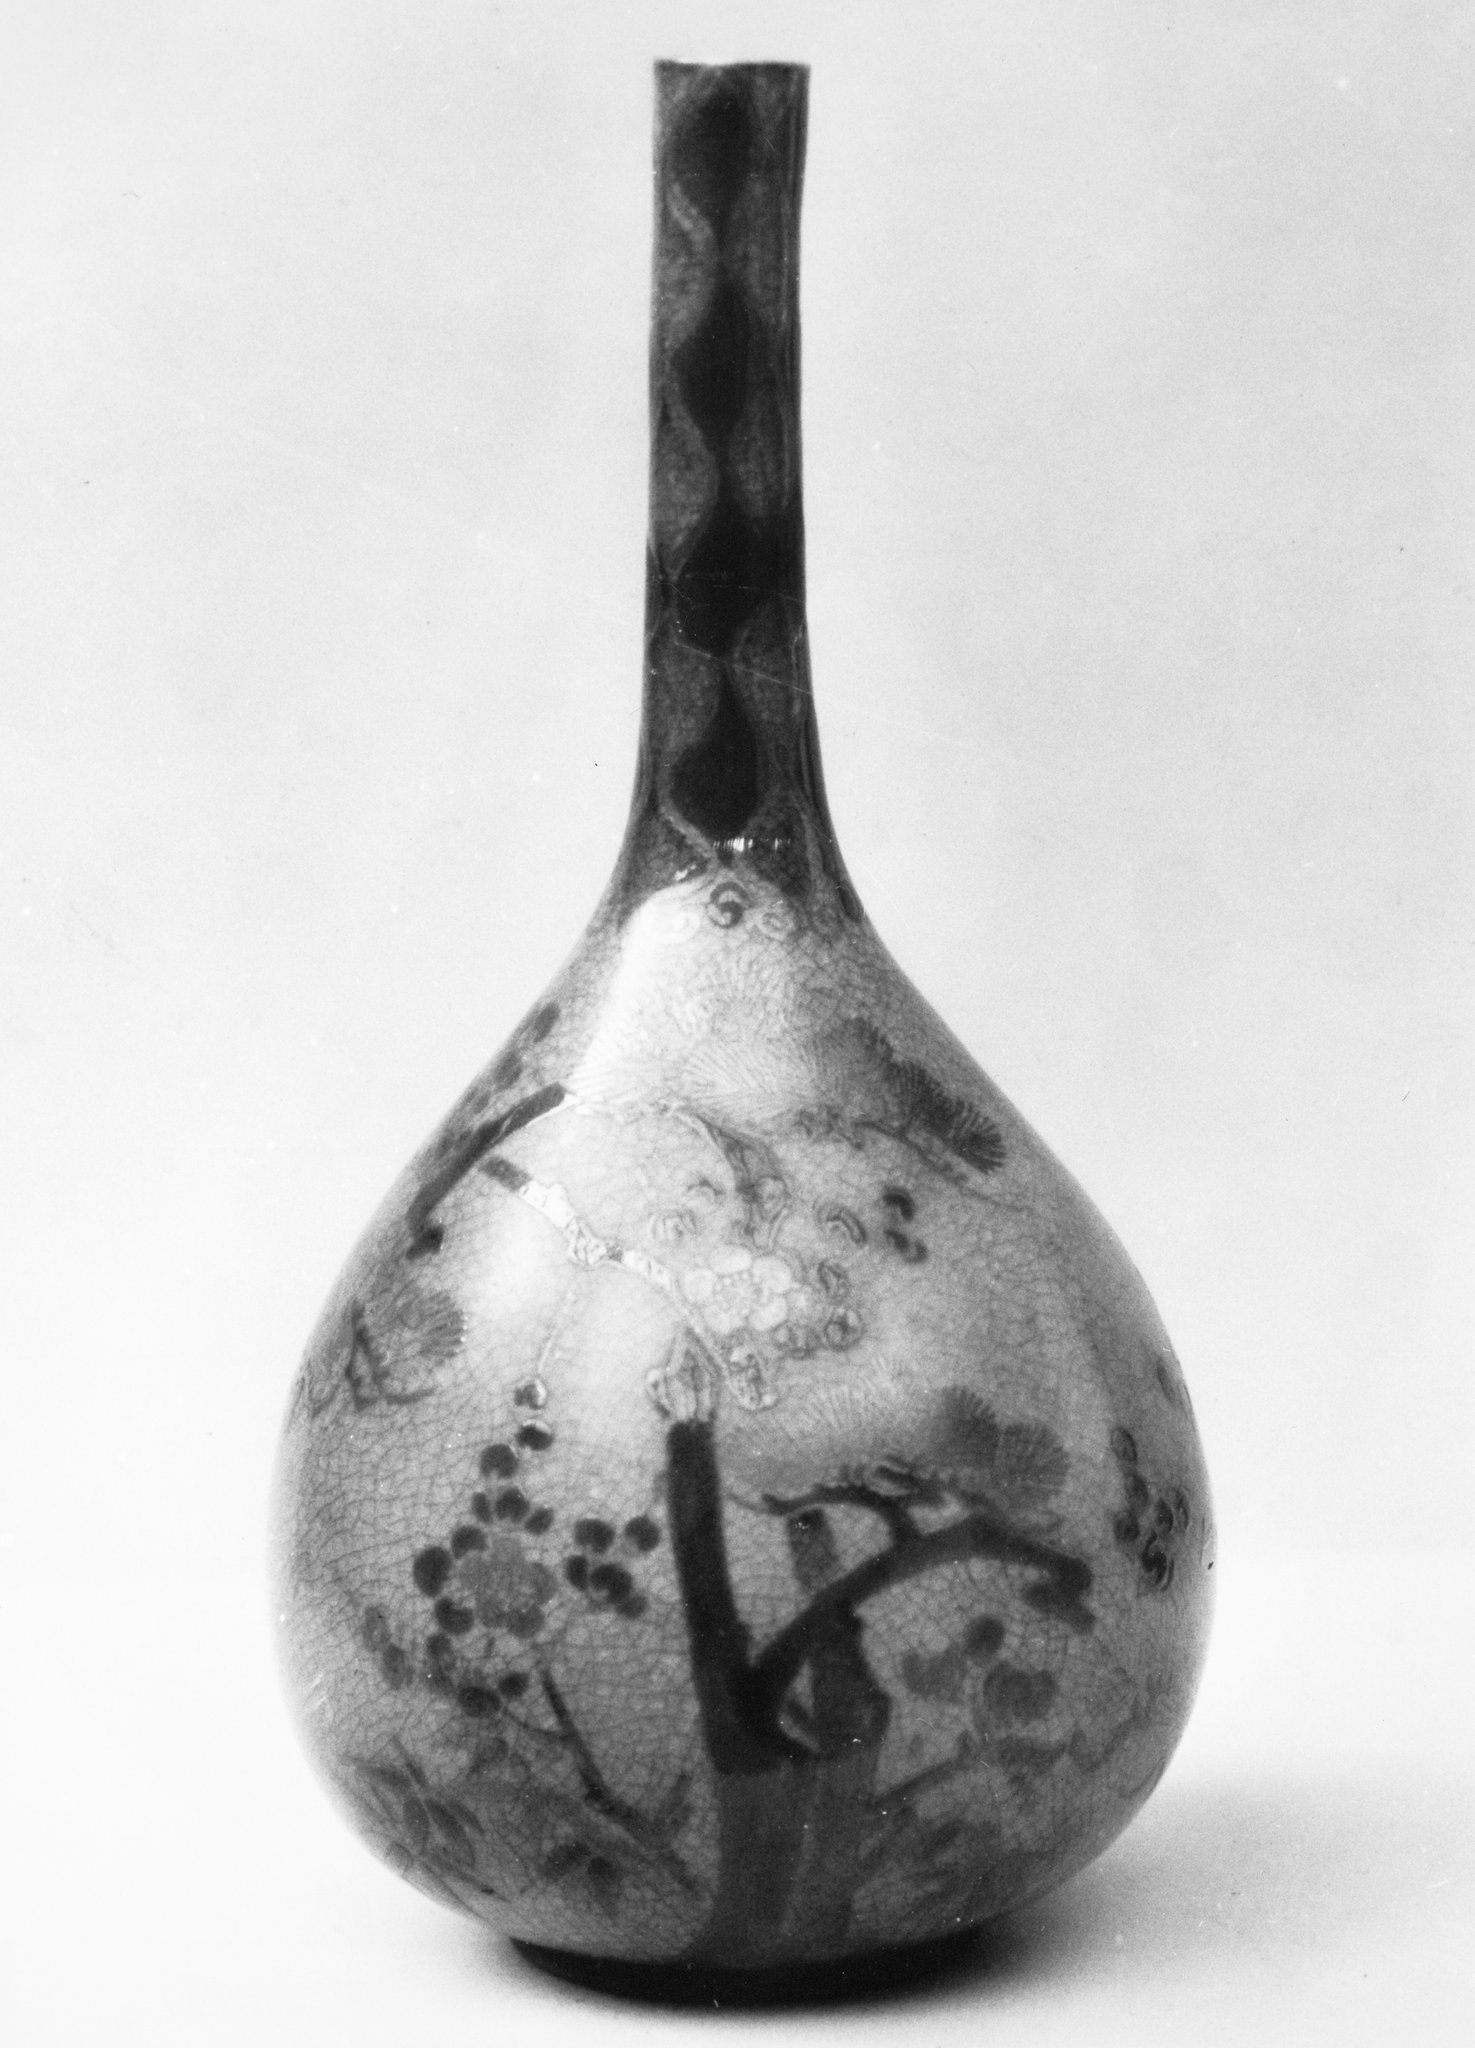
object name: wine bottle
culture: japanese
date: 1800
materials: enamel, pottery